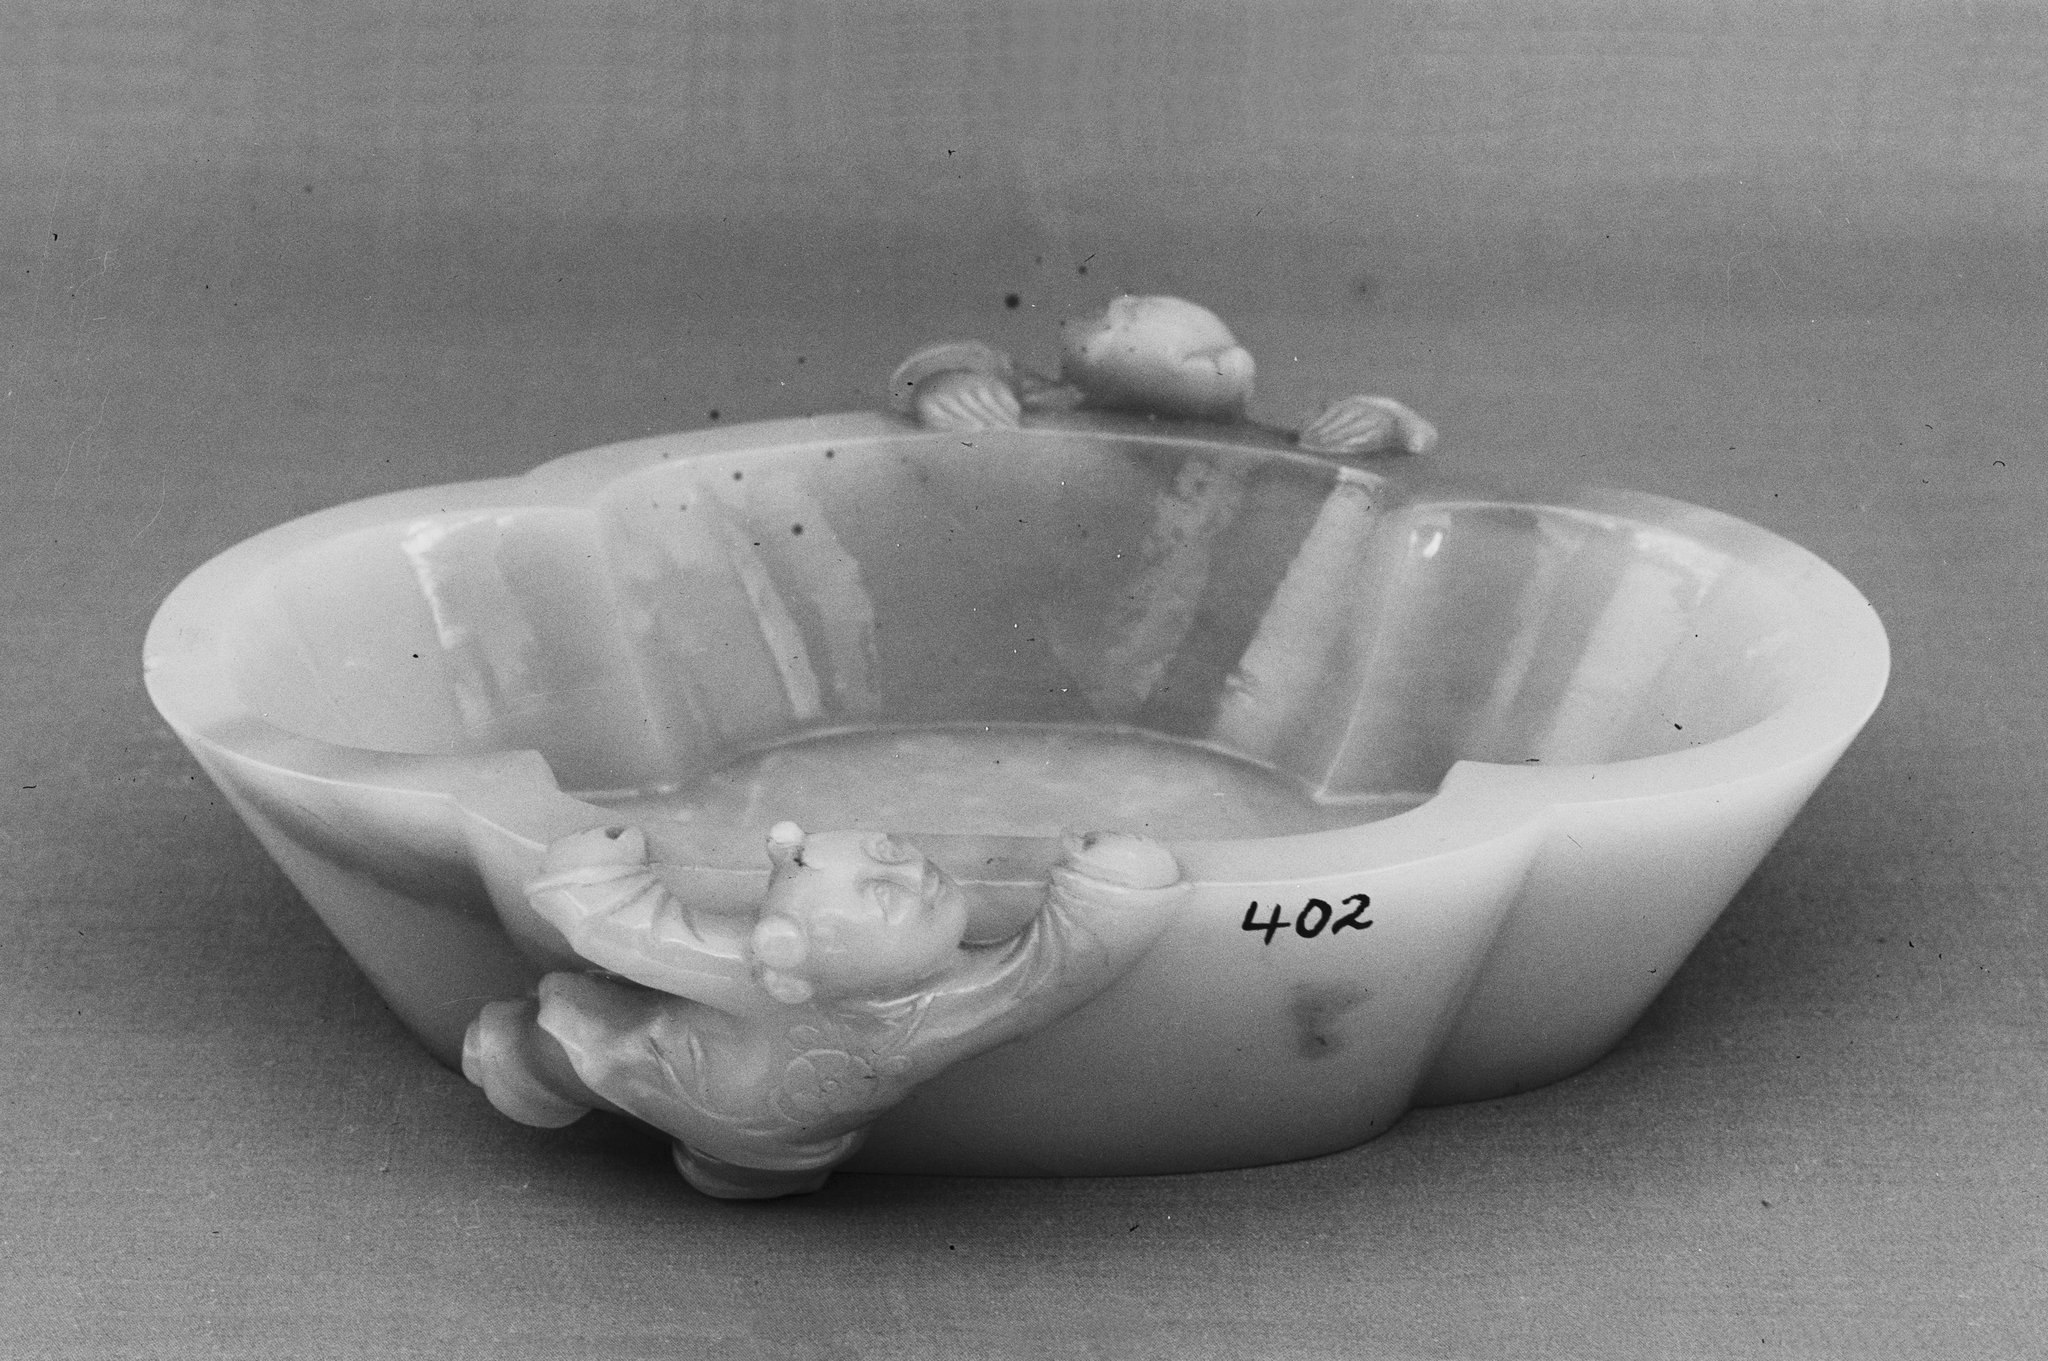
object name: dish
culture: chinese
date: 1368-1644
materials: jade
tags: men